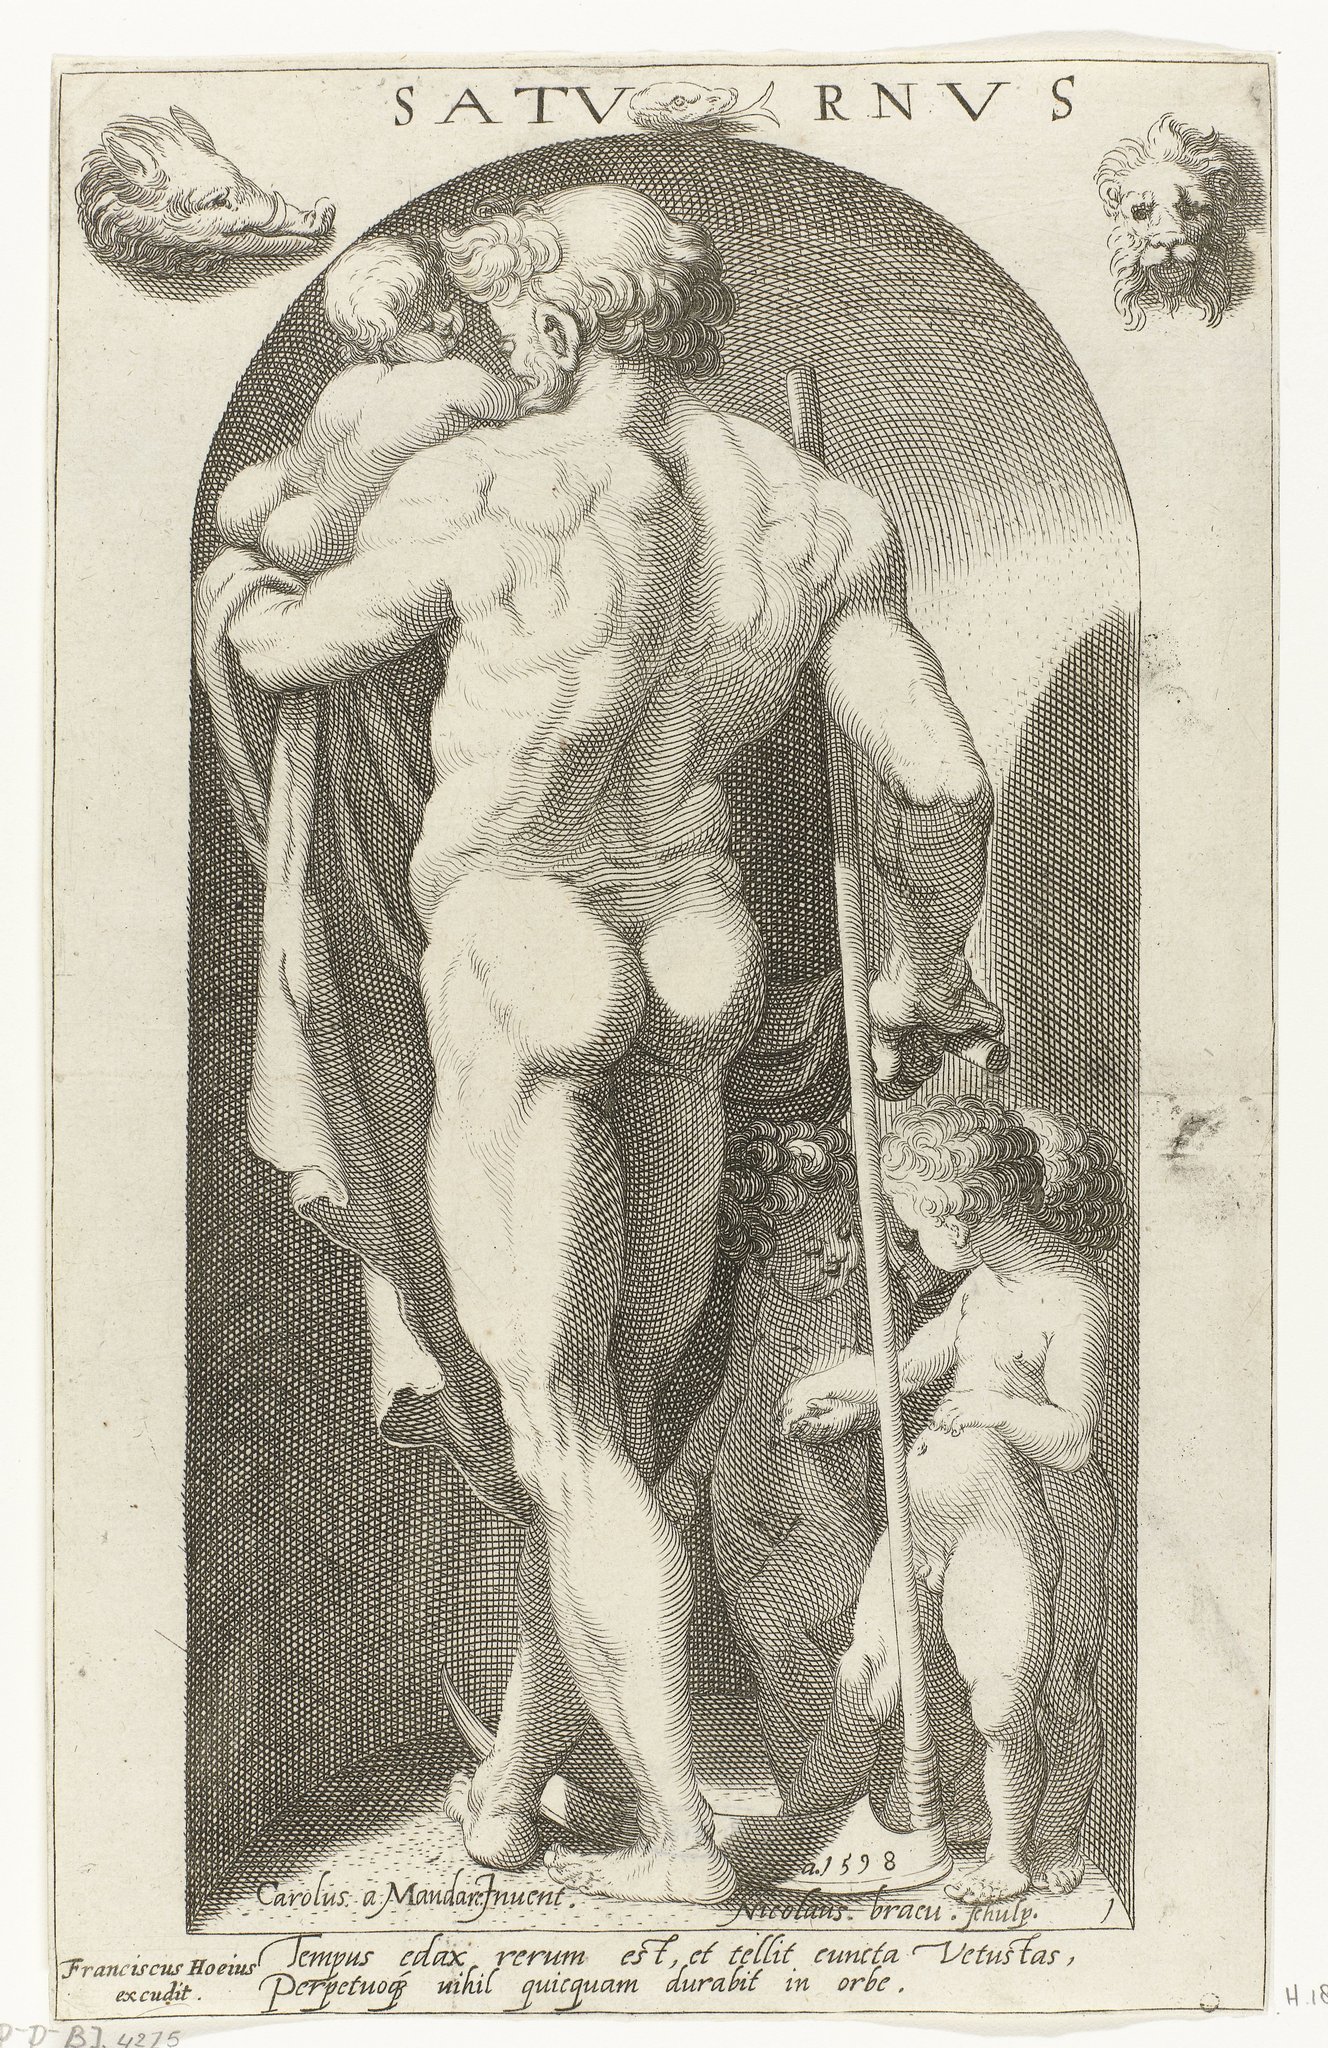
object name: print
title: Antieke Goden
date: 1598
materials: paper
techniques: engraving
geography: haarlem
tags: (story of) saturn (cronus)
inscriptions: collector's mark: Lugt 2228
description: Een beeld van de god Saturnus in een nis geplaatst. Saturnus is met zijn kinderen afgebeeld. Als god van de landbouw heeft Saturnus een zeis als attribuut. Aan de muur hangen nog andere attributen. Onder de prent een Latijns vers.